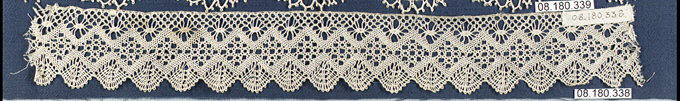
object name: piece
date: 1801-1900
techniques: lace